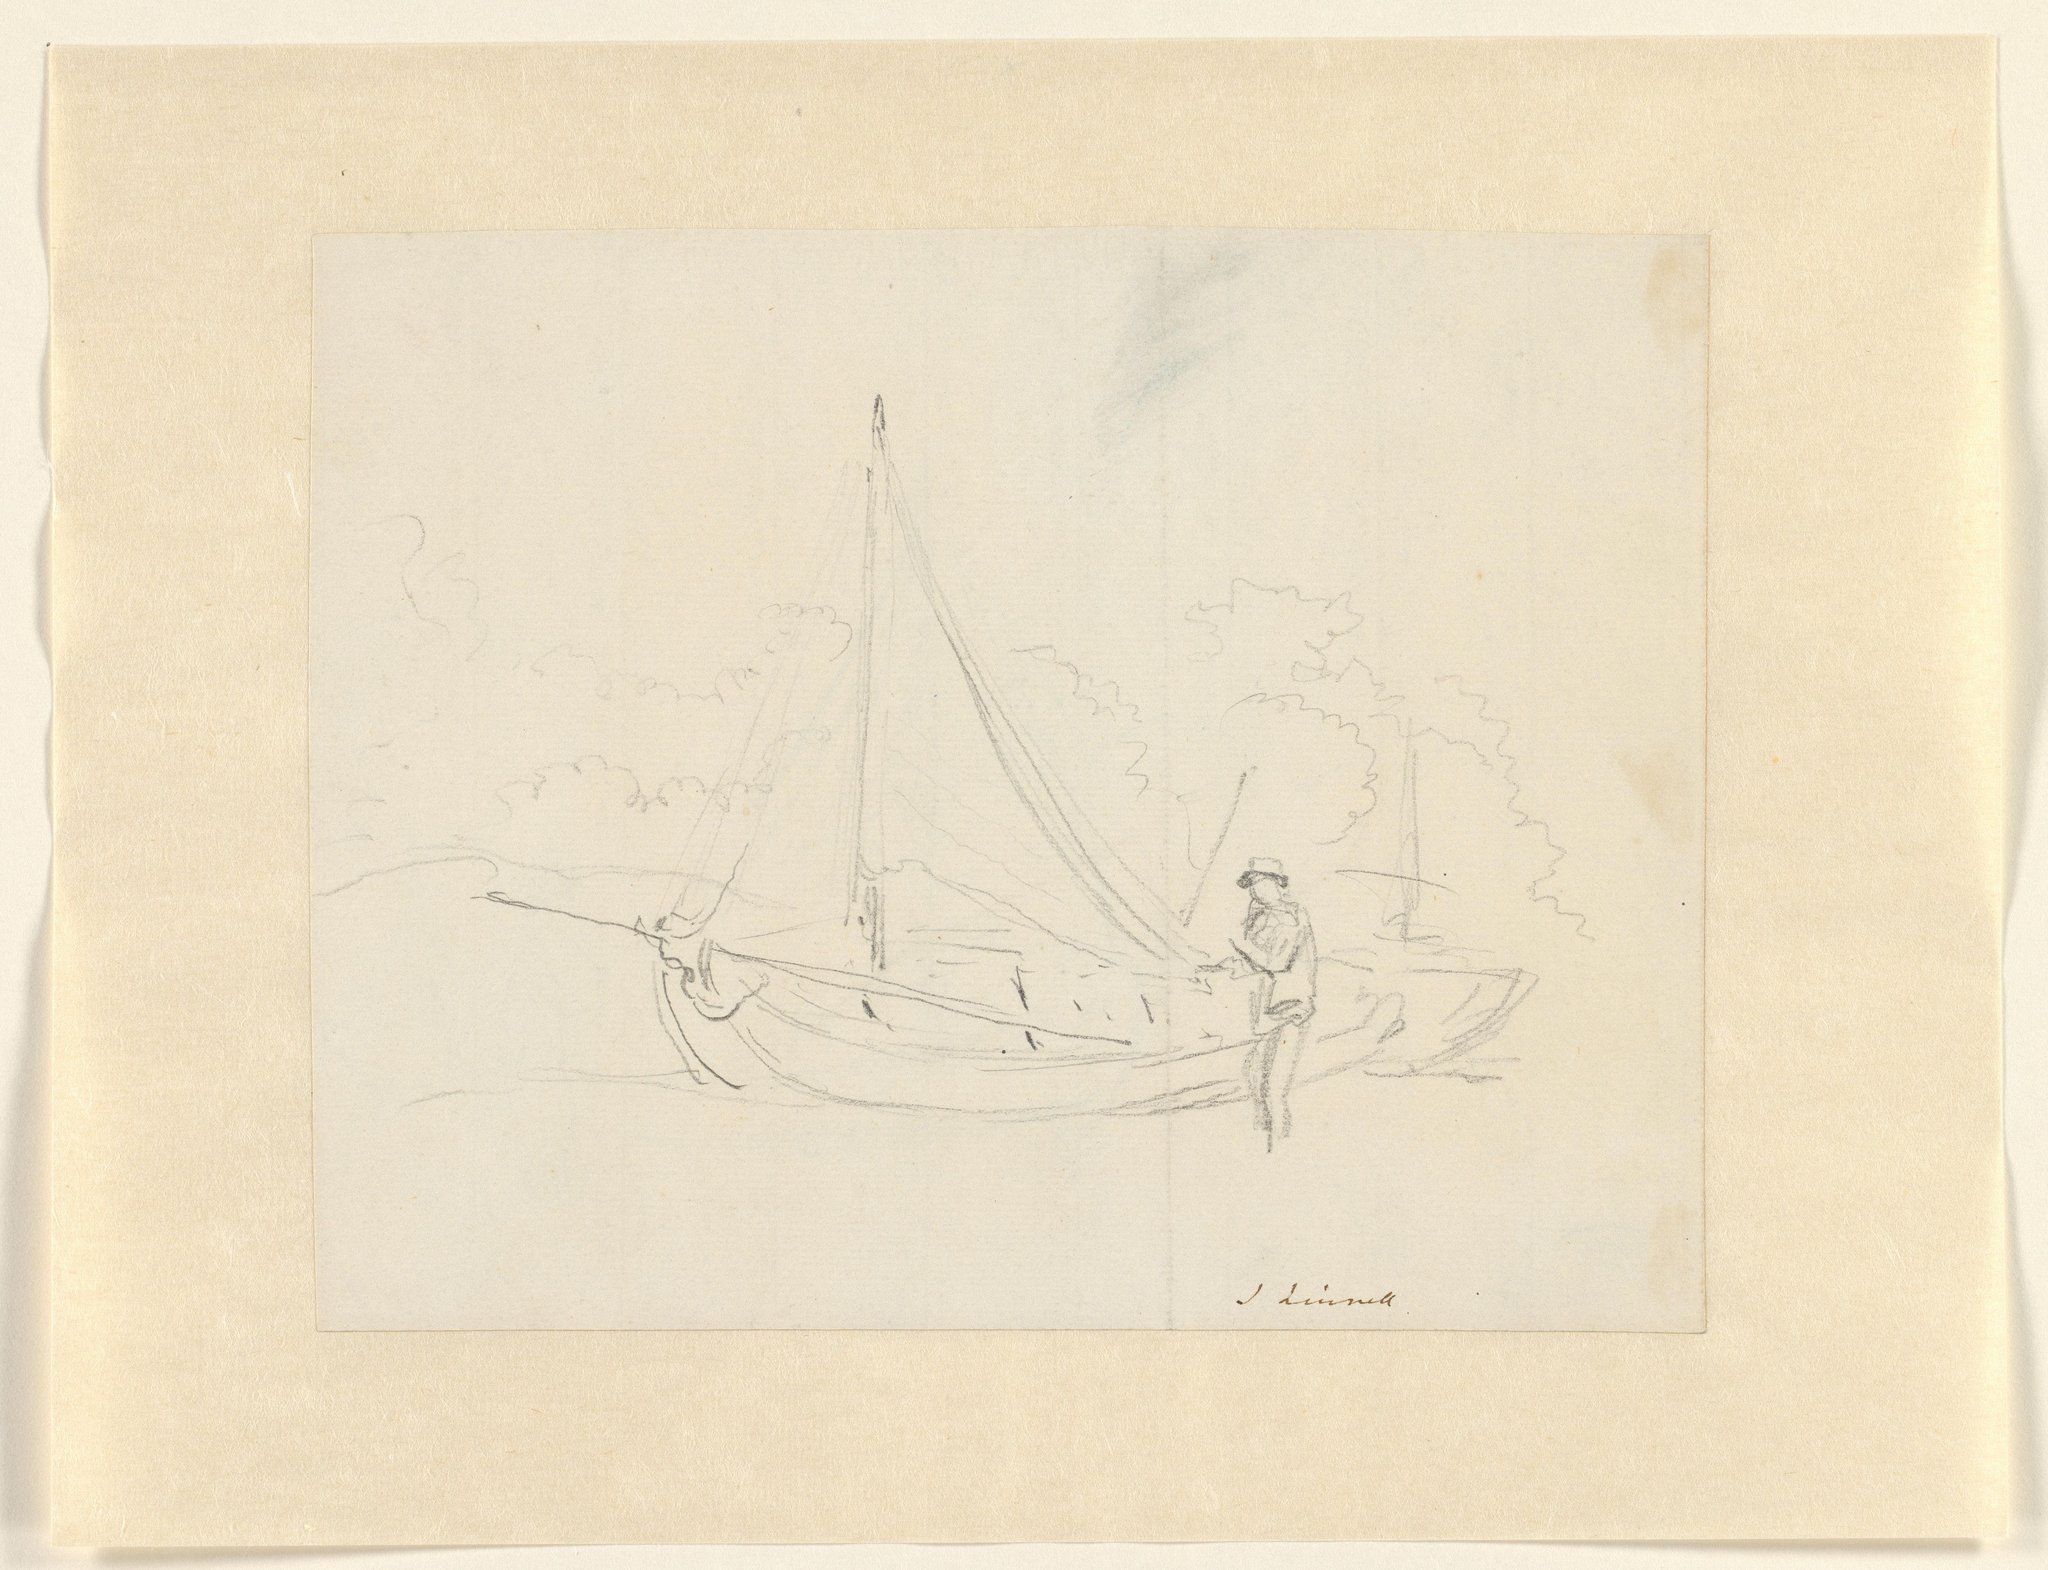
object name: drawing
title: Figuur bij een zeilschip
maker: john linnell (ii)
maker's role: draughtsman, print maker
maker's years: 1792-1882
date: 1802-1882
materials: paper, pencil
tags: sailing-ship, sailing-boat